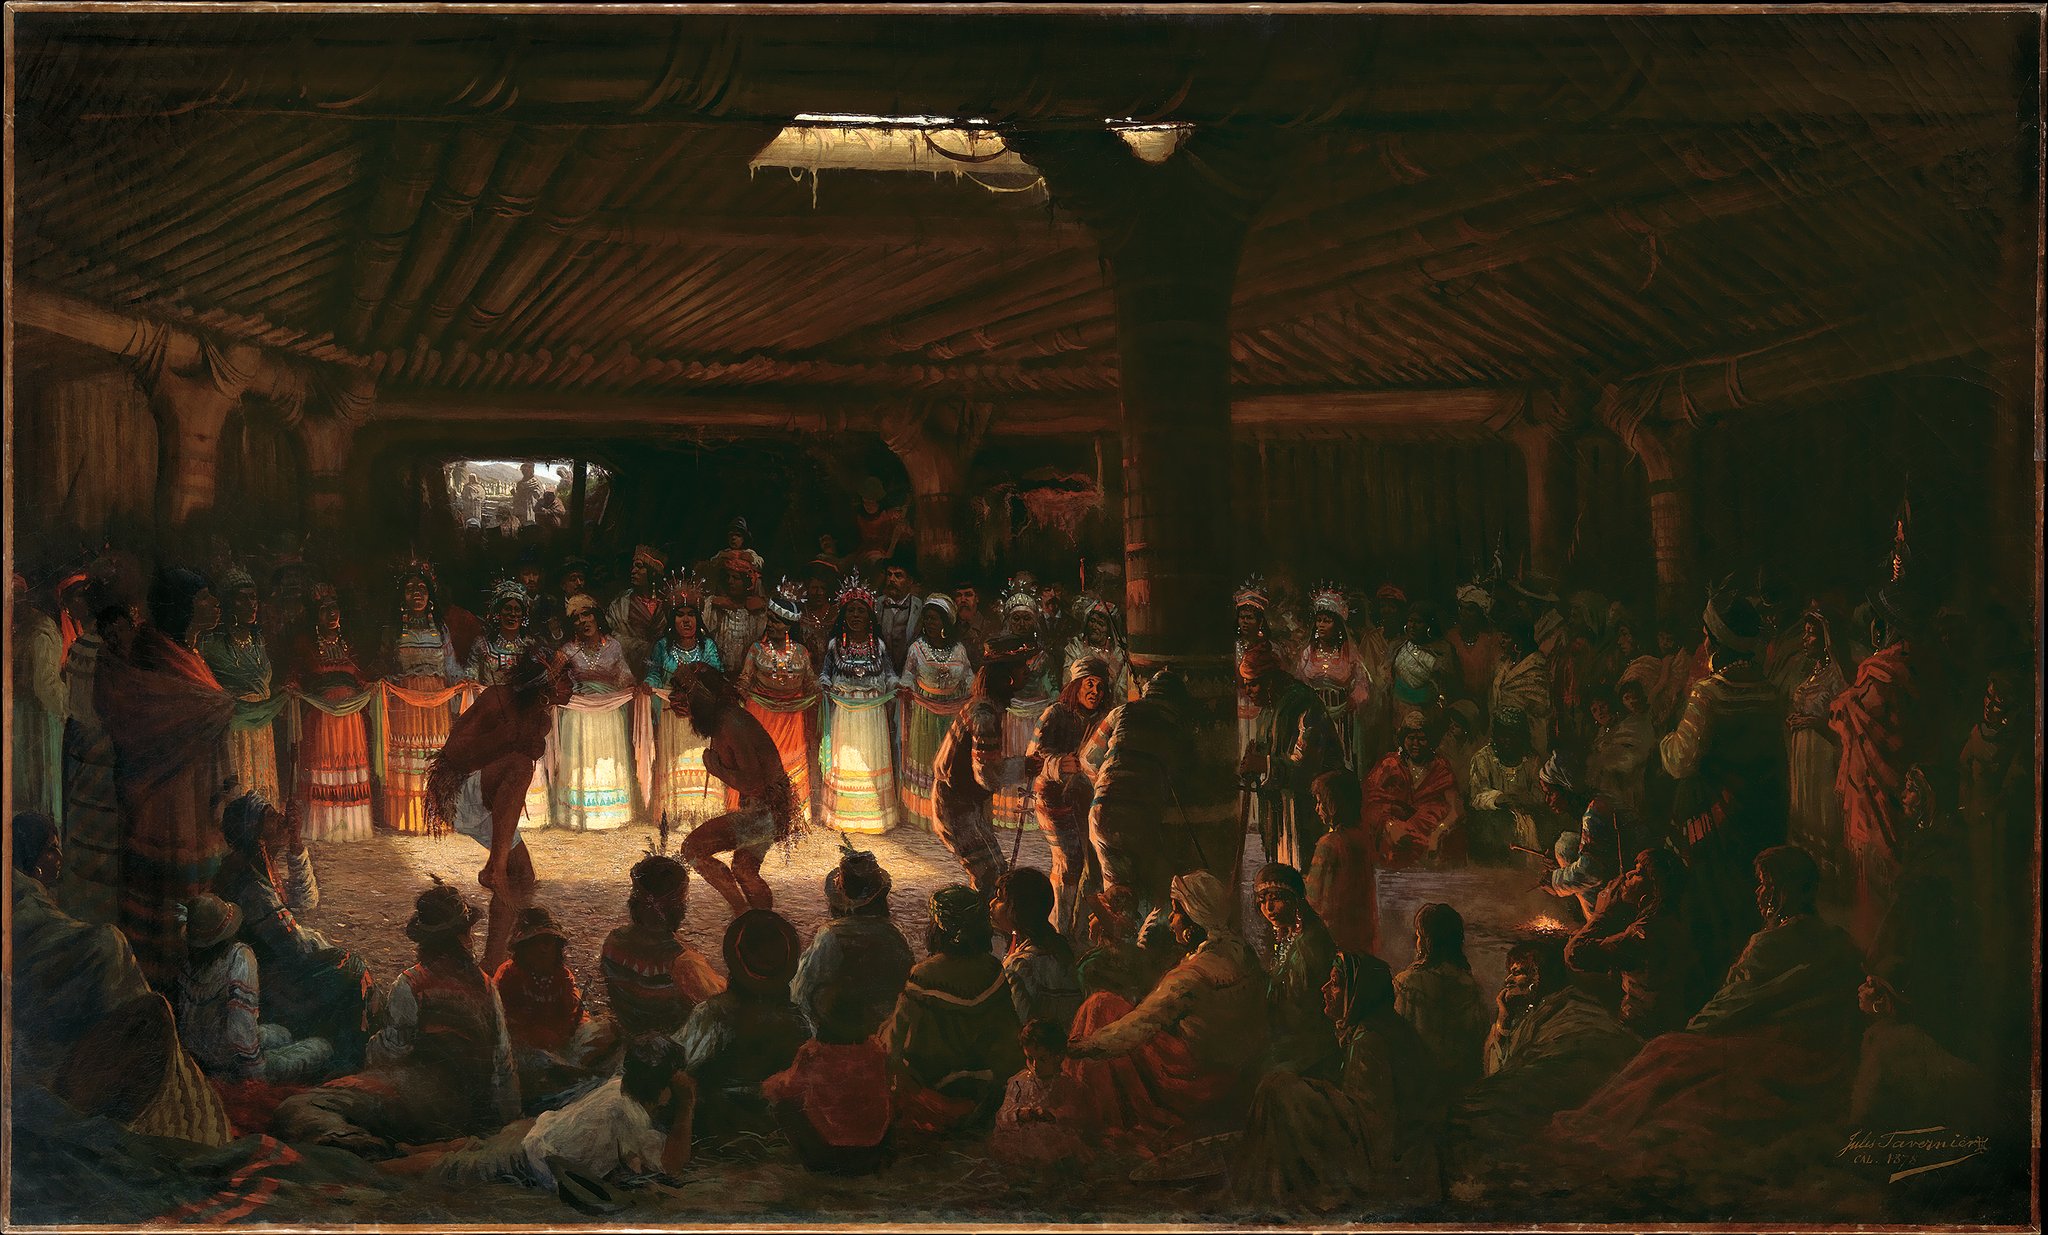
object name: painting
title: Dance in a Subterranean Roundhouse at Clear Lake, California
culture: american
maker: jules tavernier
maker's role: artist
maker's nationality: american, born france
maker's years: 1844-1889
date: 1878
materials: canvas, oil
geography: united states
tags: men,women,dancing,dancers